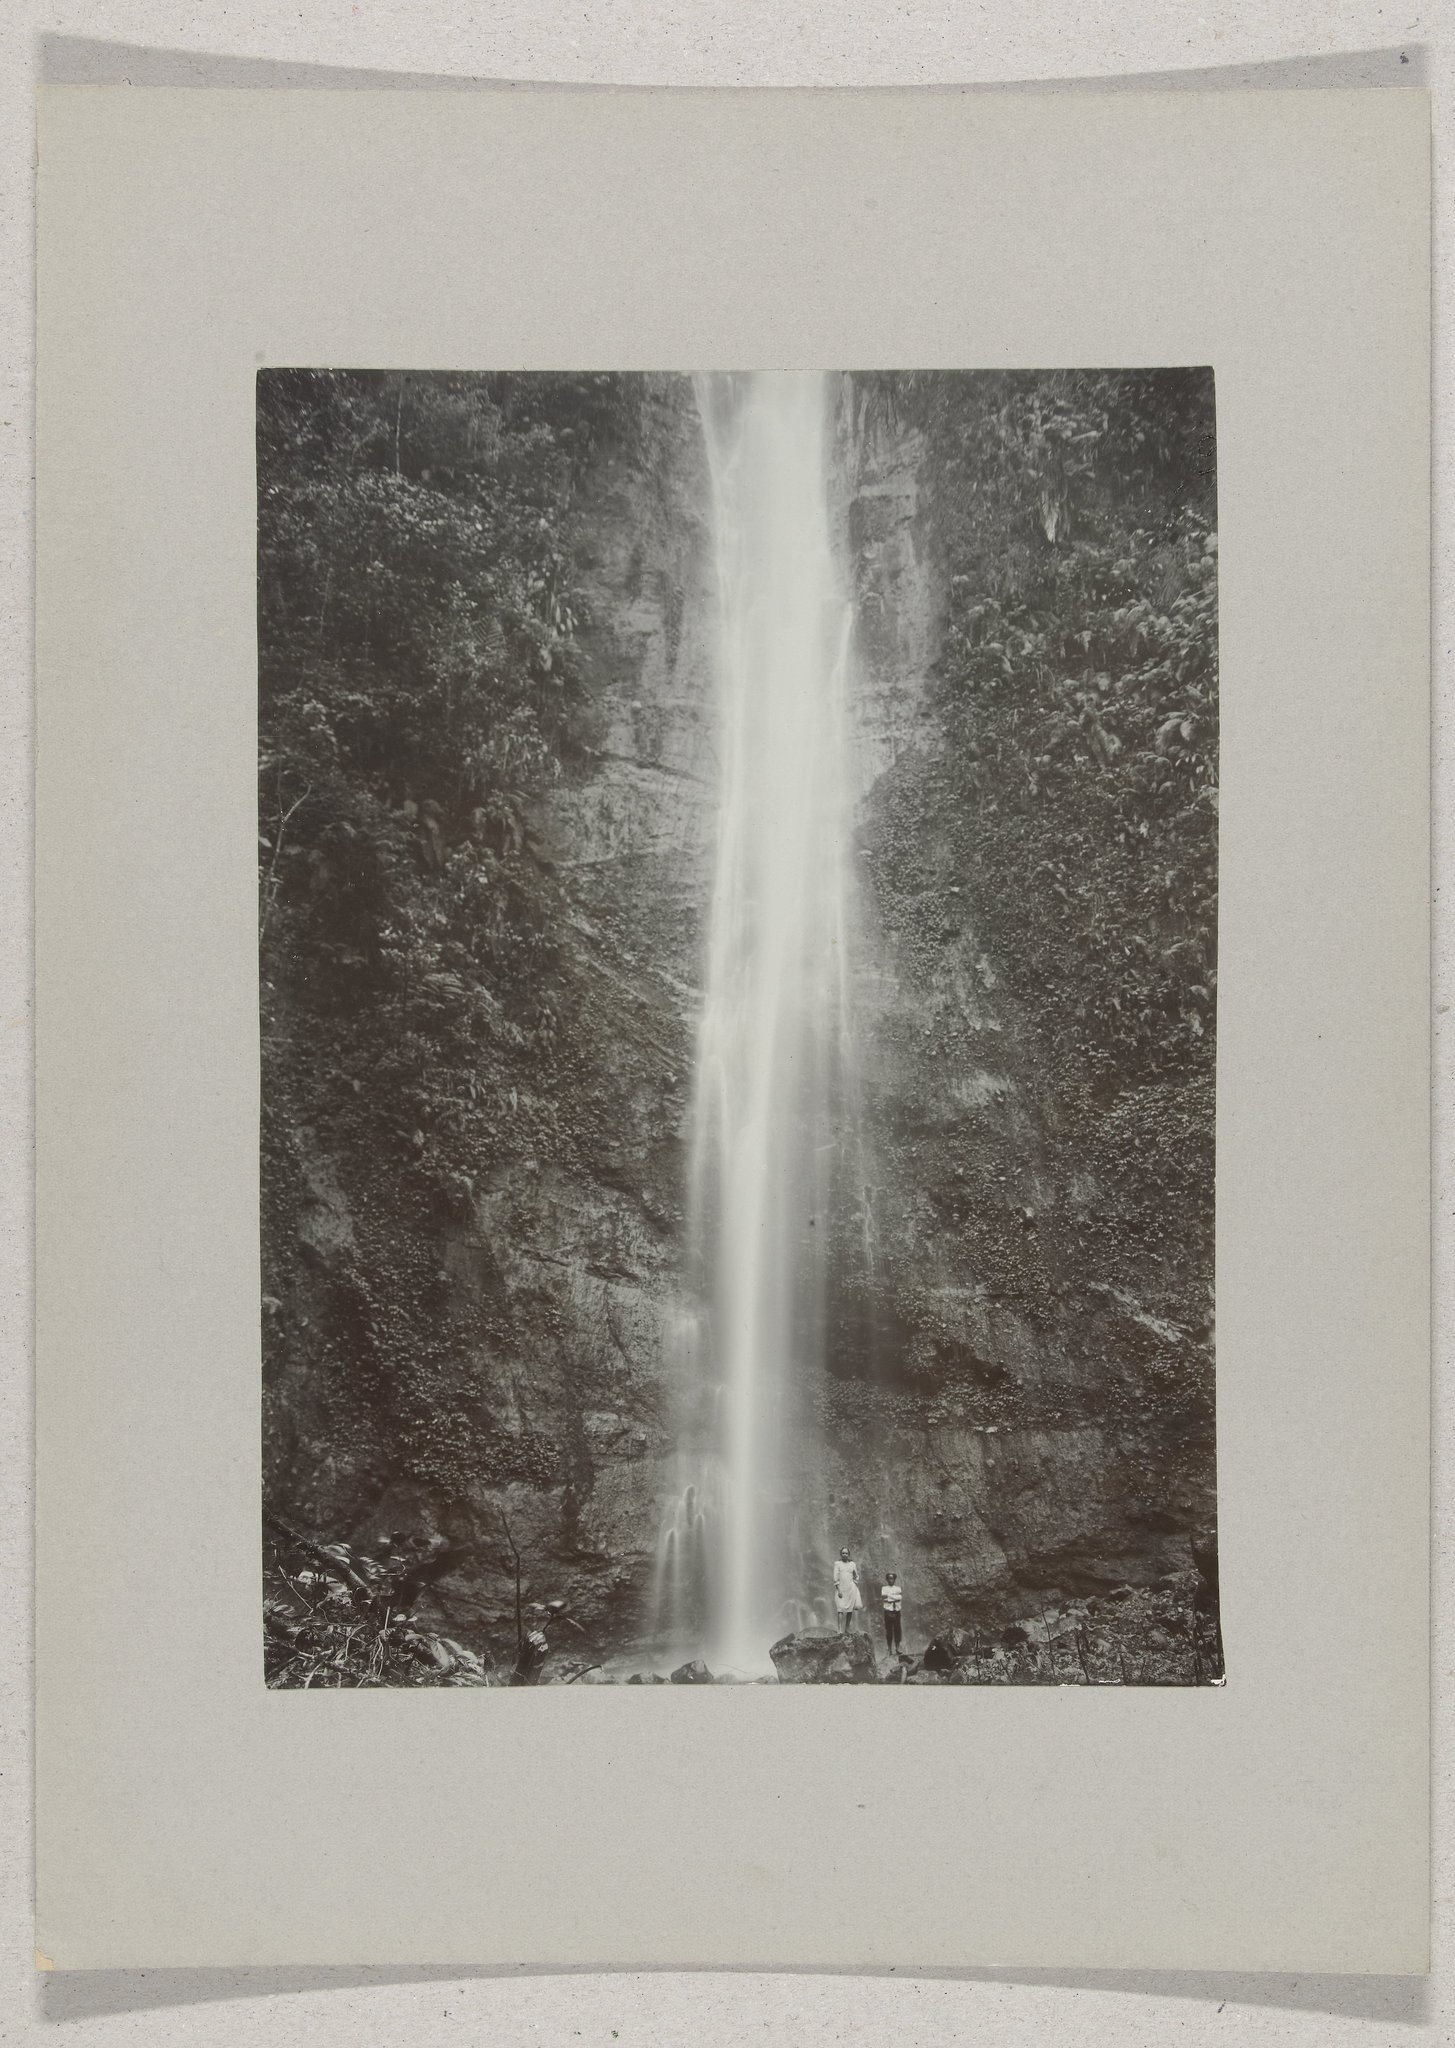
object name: photograph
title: Waterval bij Soekaboemi op Java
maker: Anonymous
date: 1895-1915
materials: cardboard, paper, photographic support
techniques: gelatin silver print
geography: buitenzorg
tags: waterfall, indonesia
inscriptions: annotation: ‘54. Waterval b/ Soekaboemi’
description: Waterval bij Soekaboemi, Java, Nederlands-Indië